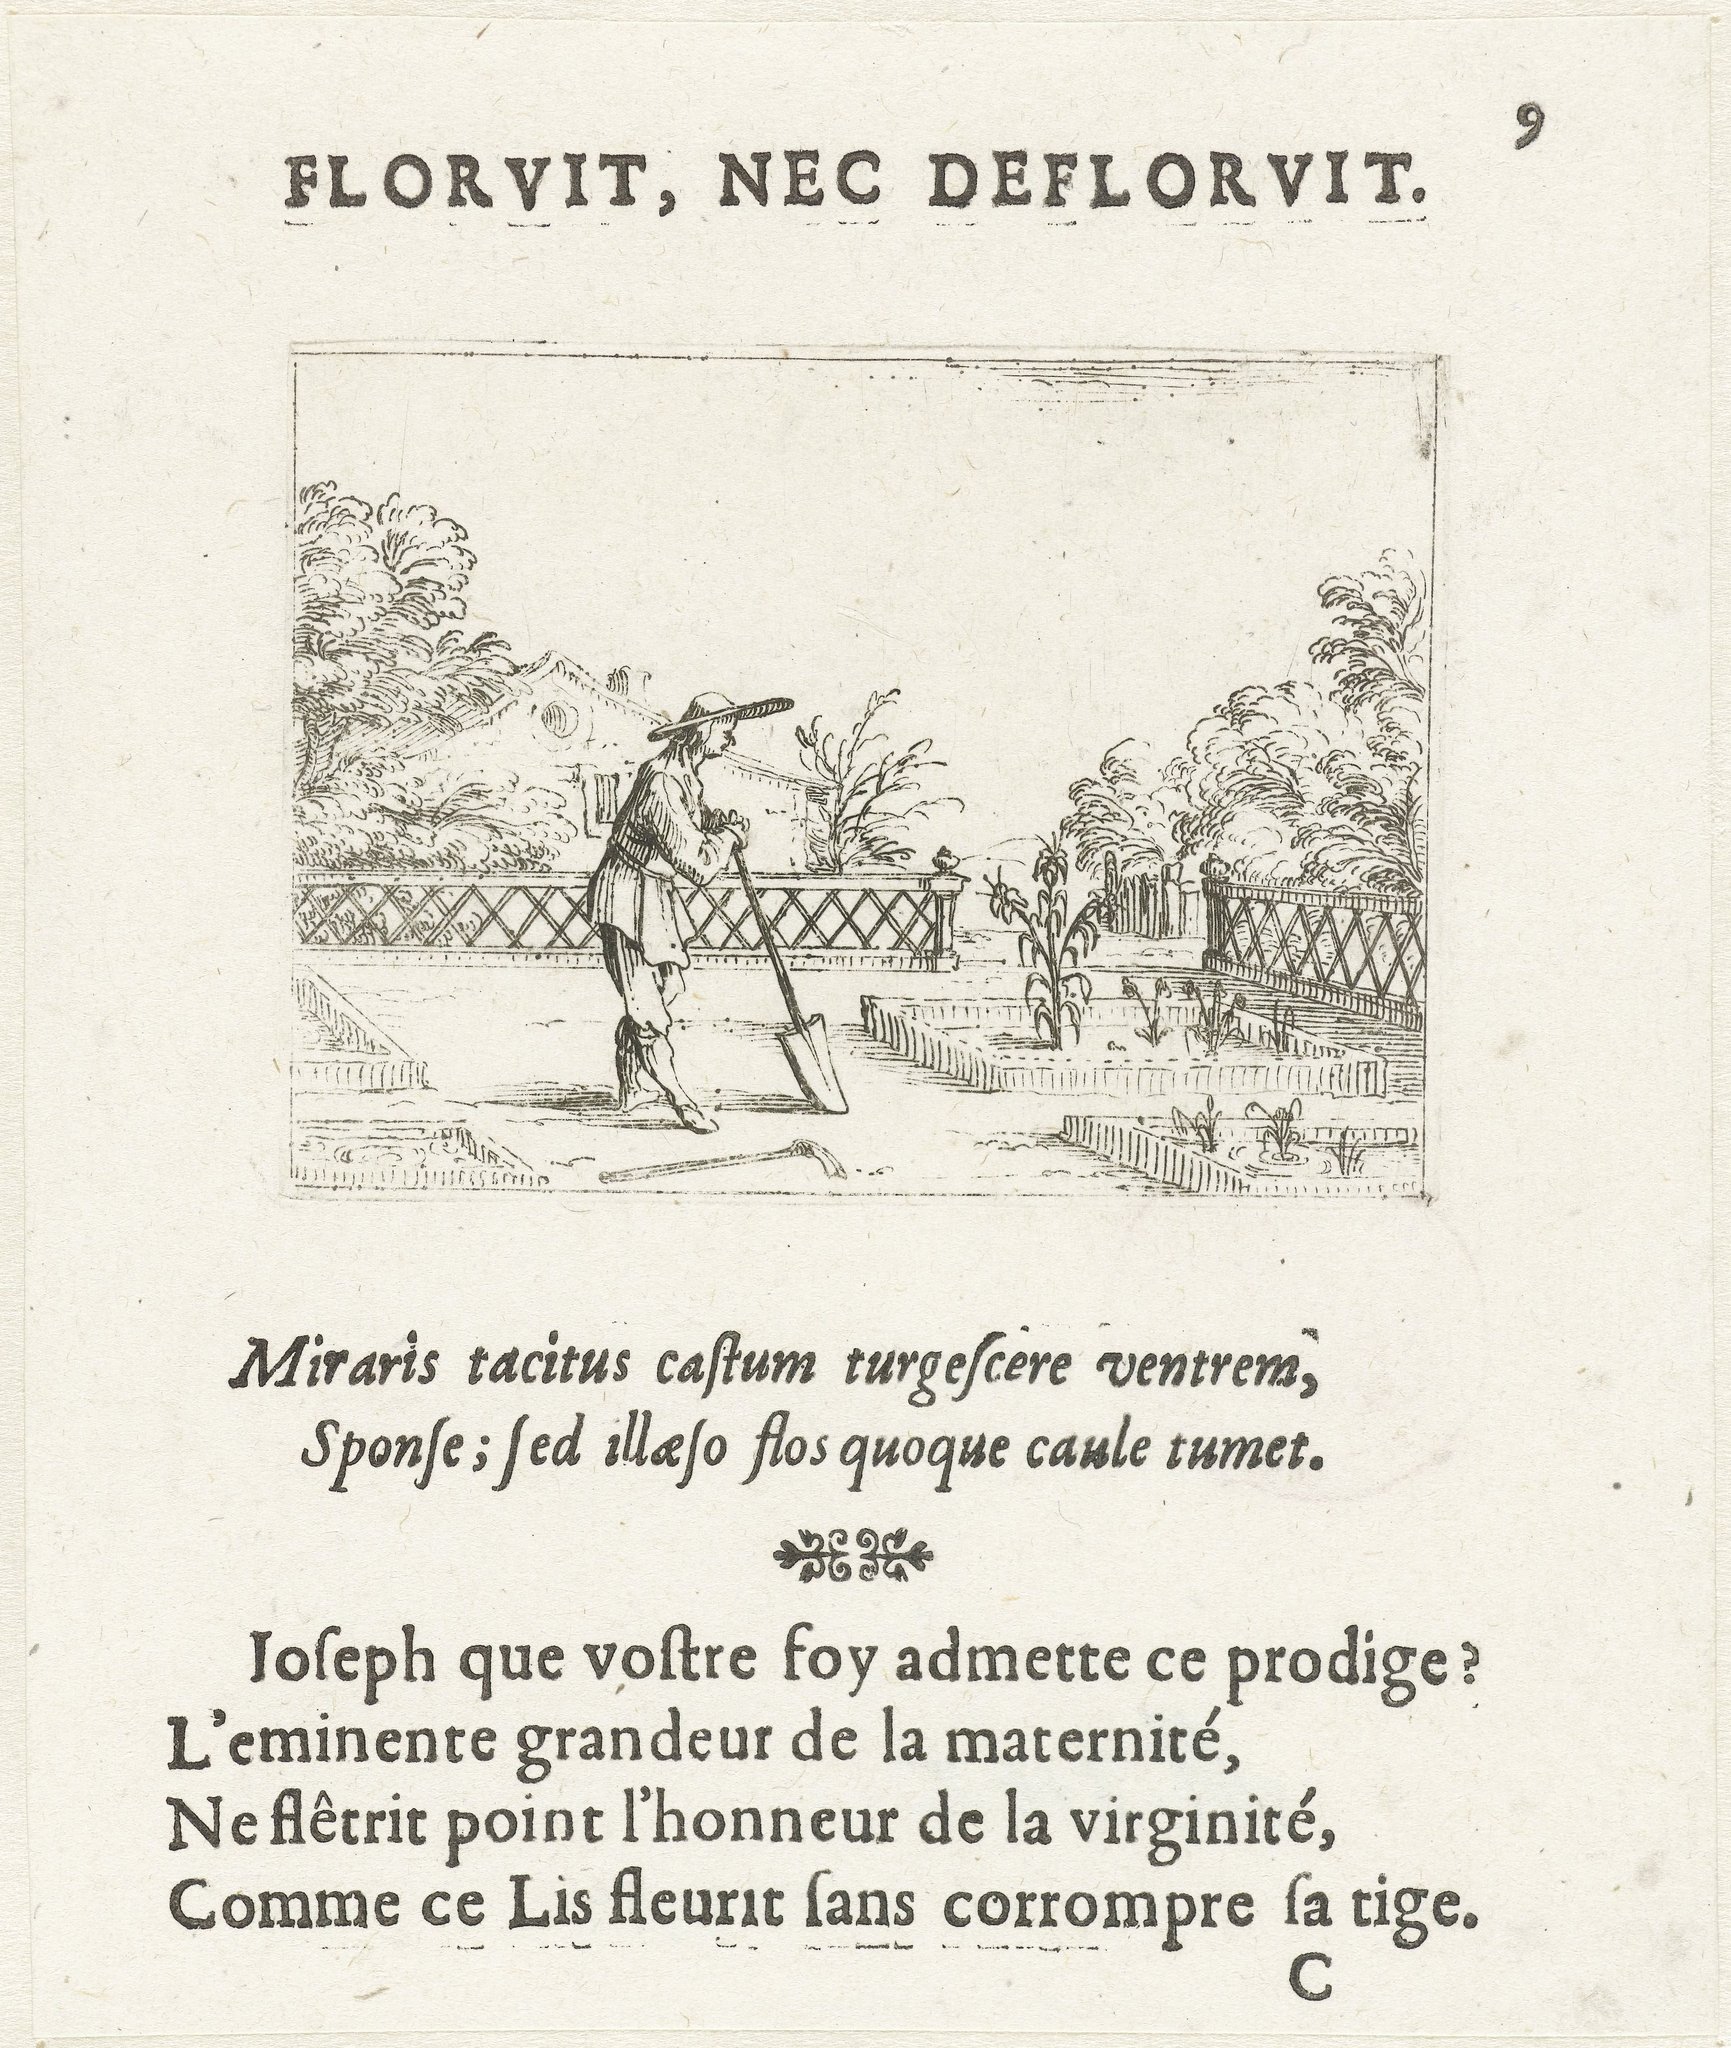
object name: cognizance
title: Leven van Maria in emblemen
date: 1625-1629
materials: paper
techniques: etching, letterpress printing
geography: nancy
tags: gardening, flowers: lily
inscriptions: collector's mark: Lugt 240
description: Voorstelling van een tuinman die, steunend op zijn schop, de lelies in een omheinde tuin bewondert. Boven en onder deze prent Latijnse en Franse teksten in boekdruk. Dit blad is onderdeel van de embleemserie 'Leven van Maria in emblemen'. De eerste staat van deze serie behelst naast een titelpagina en 26 emblemen ook drie bladen met lofzangen op Maria in boekdruk zonder afbeelding.